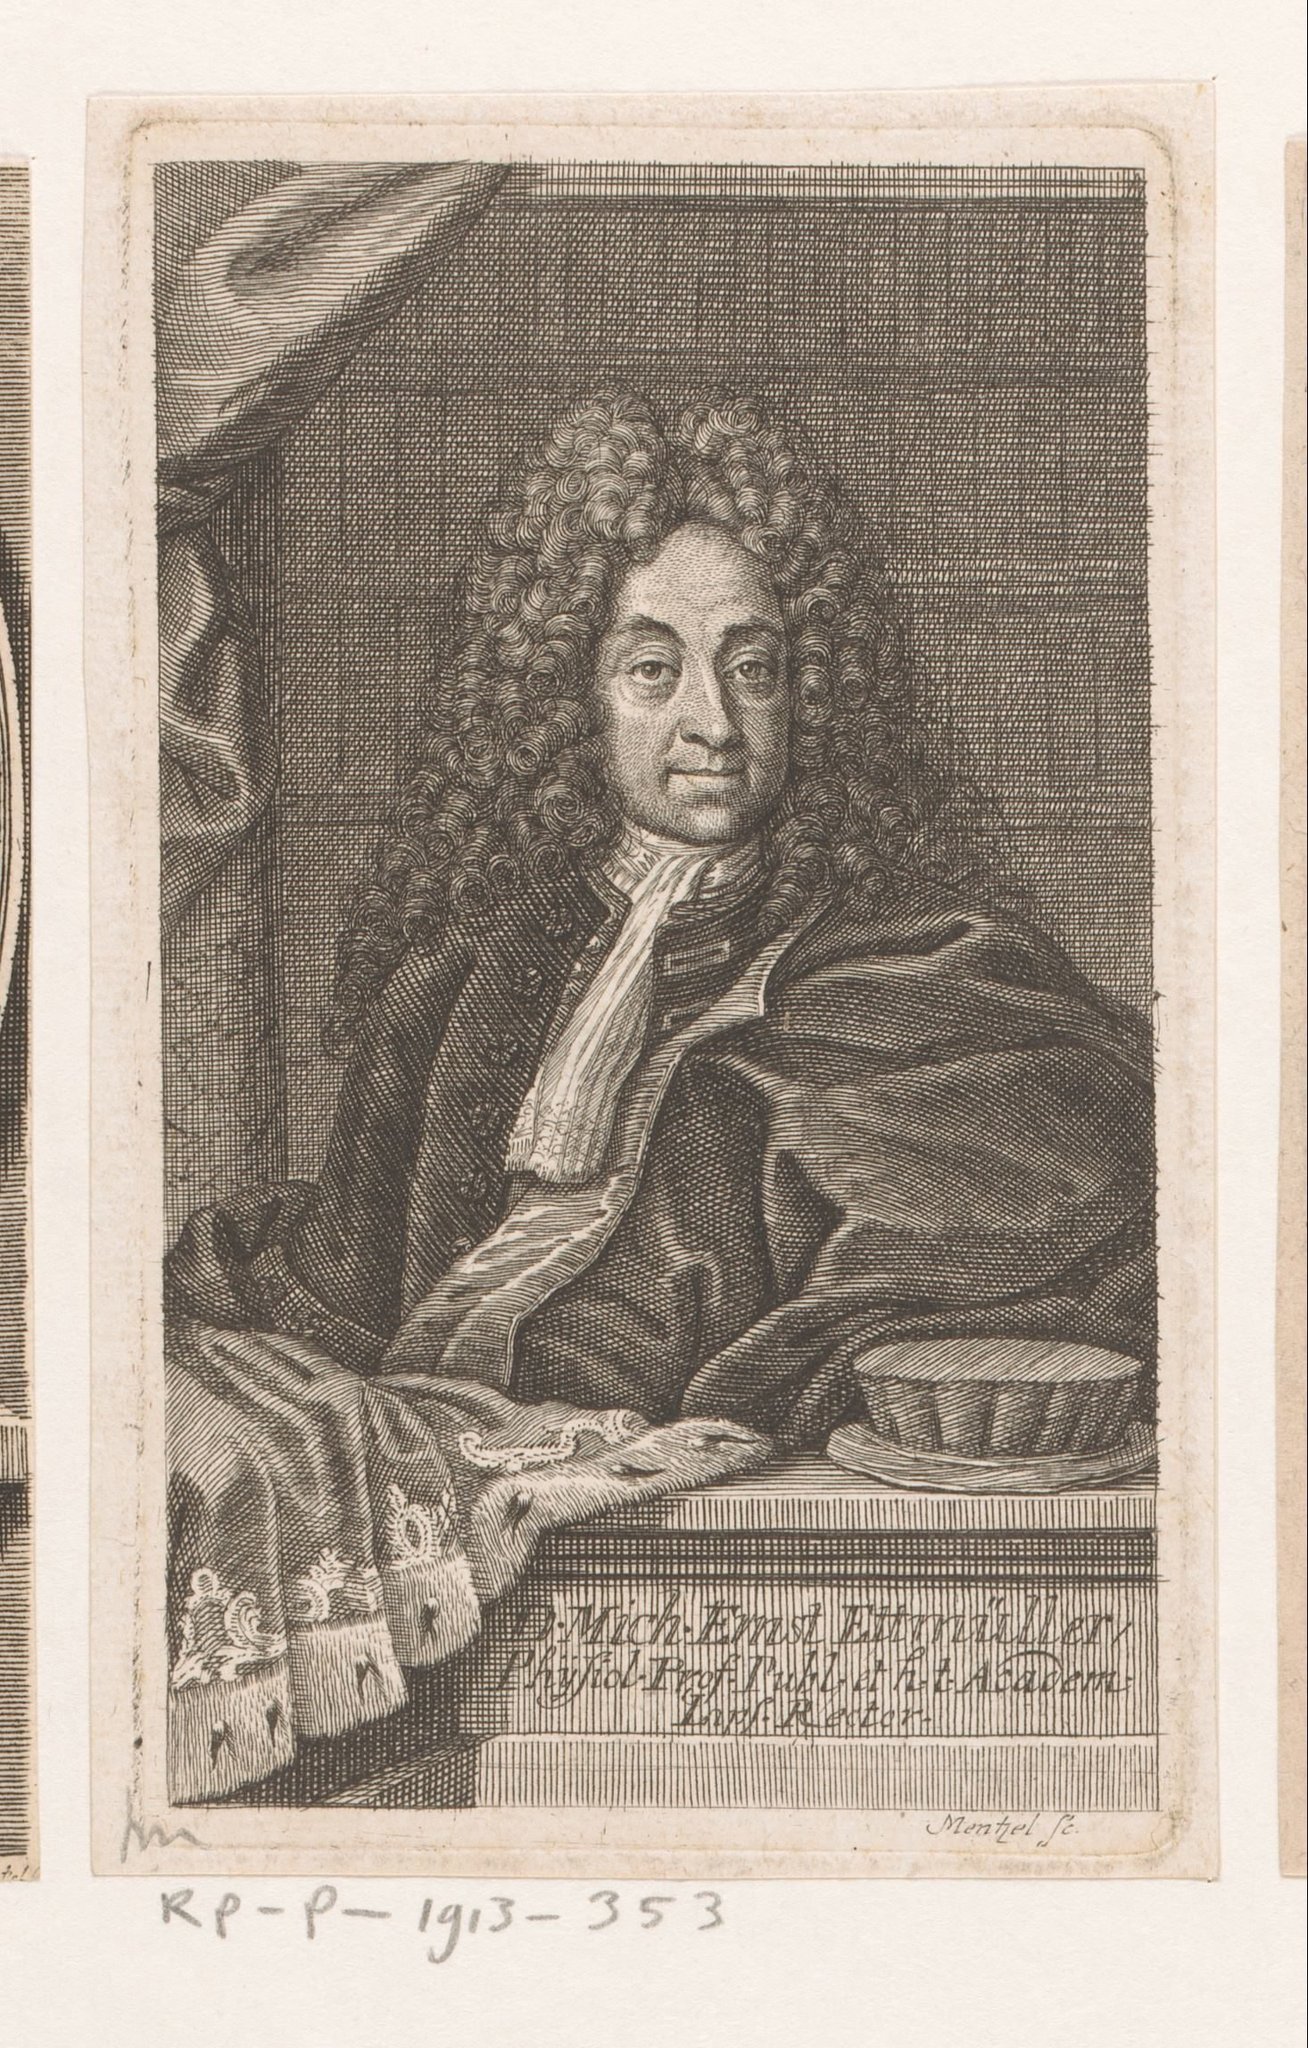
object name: print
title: Portret van Michael Ettmüller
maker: johann georg mentzel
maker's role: print maker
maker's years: 1677-1743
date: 1687-1743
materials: paper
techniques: engraving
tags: michael ettmüller, historical persons, wig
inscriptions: collector's mark: Lugt 2228